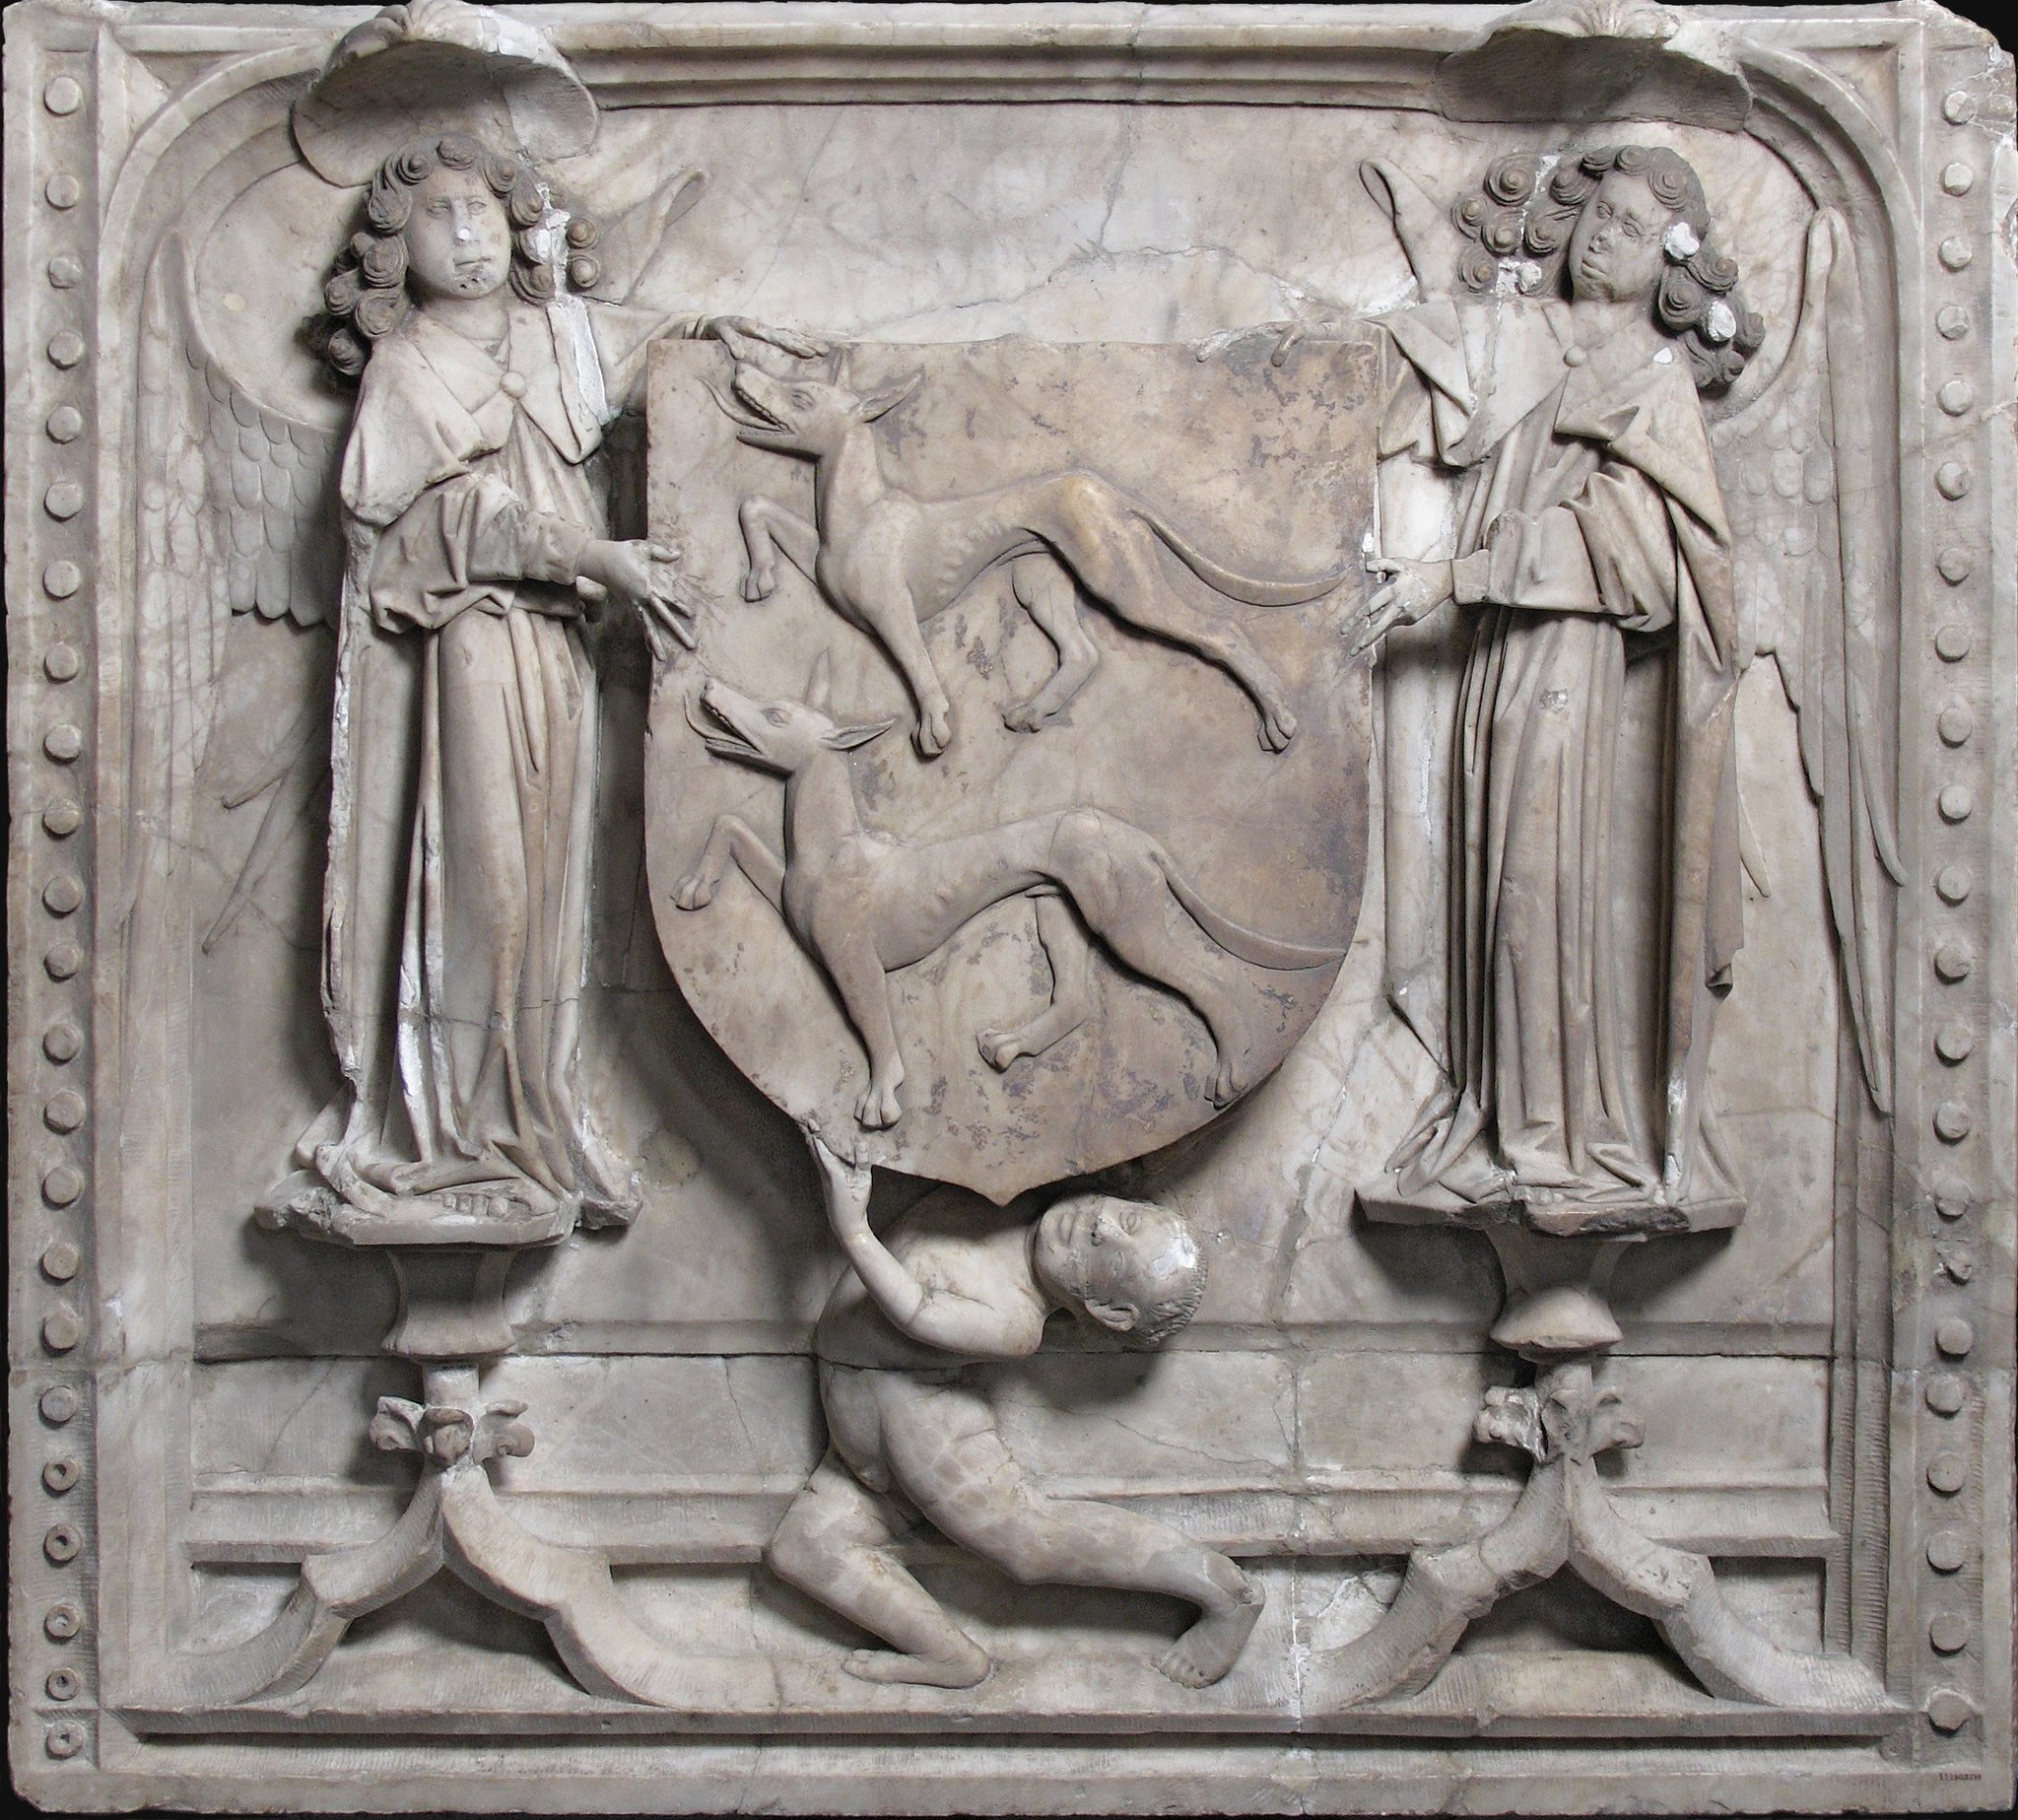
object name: panel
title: Panel from the Tomb of Don Garcia Osorio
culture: spanish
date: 1501-1600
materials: alabaster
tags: boys,angels